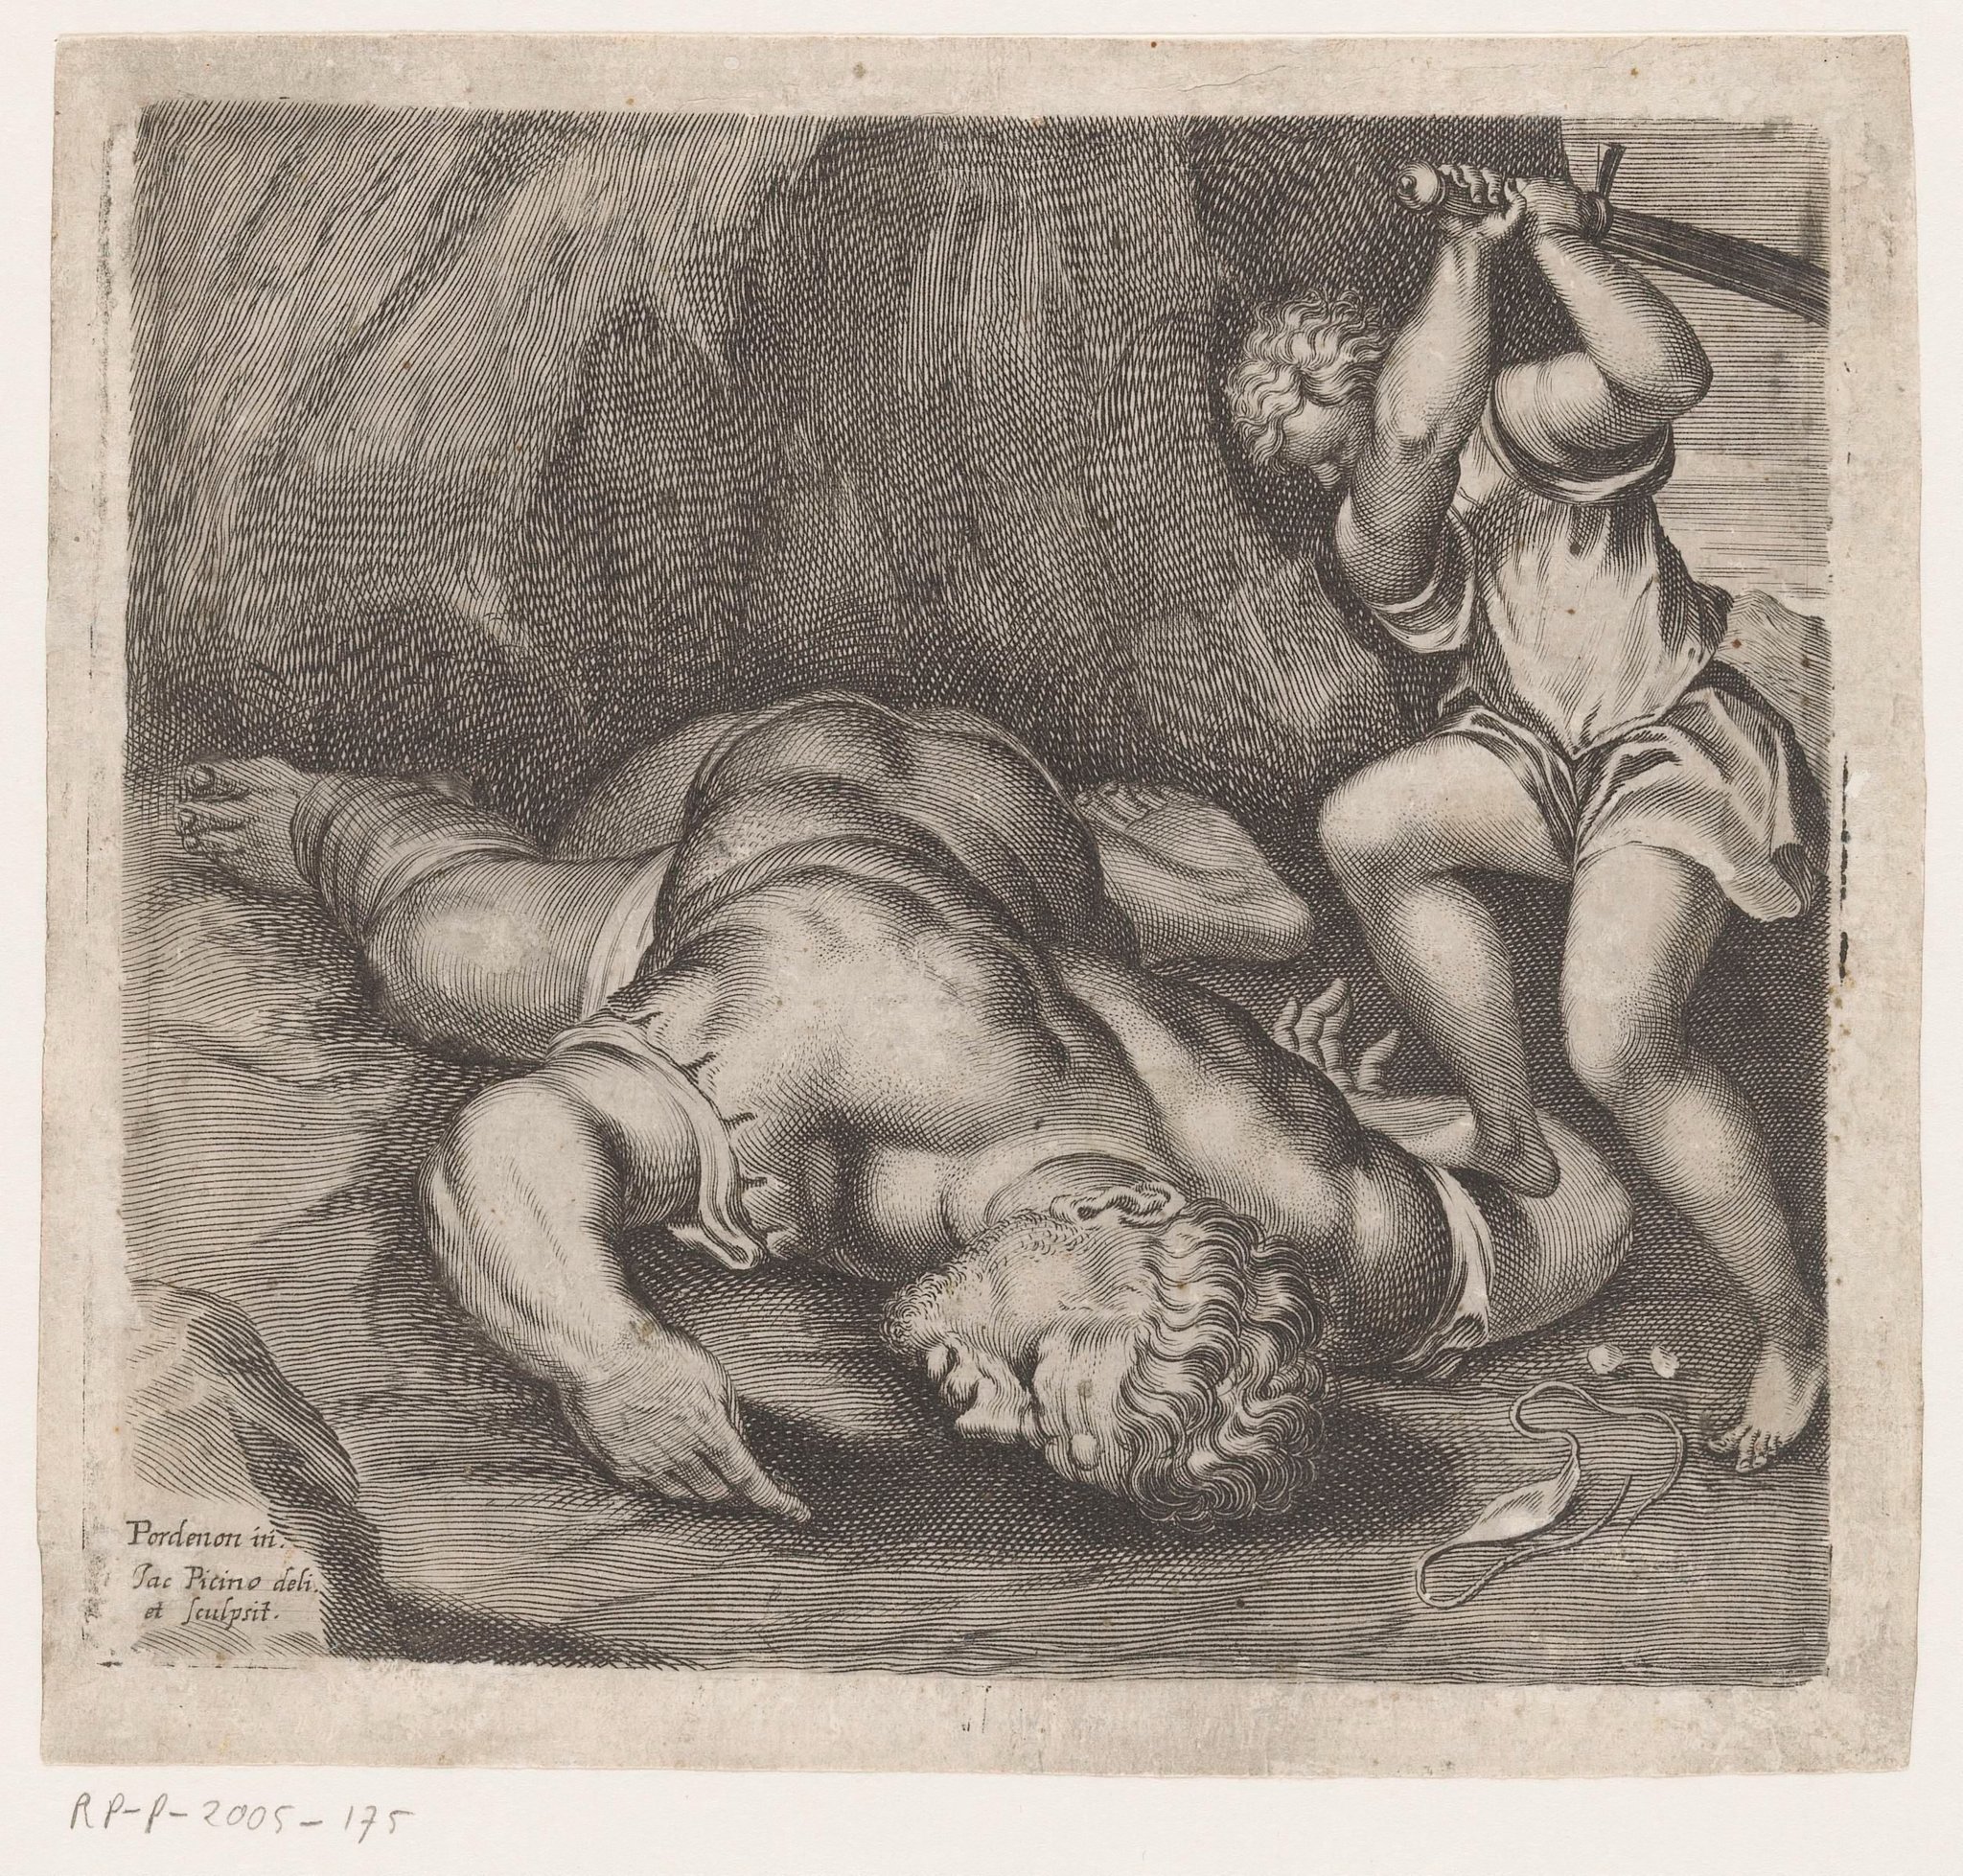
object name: print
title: David onthoofdt Goliat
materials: paper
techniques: engraving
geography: venice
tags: david beheads goliath with a sword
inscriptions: collector's mark: Lugt 2228, collector's mark: Lugt 2760, inscription: ‘H 100 6’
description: Goliat ligt op de grond. David heft het zwaard van Goliat boven het hoofd, klaar om Goliat te onthoofden. Rechts op de voorgrond ligt de slinger waarmee David een steen tegen Goliats voorhoofd slingerde.